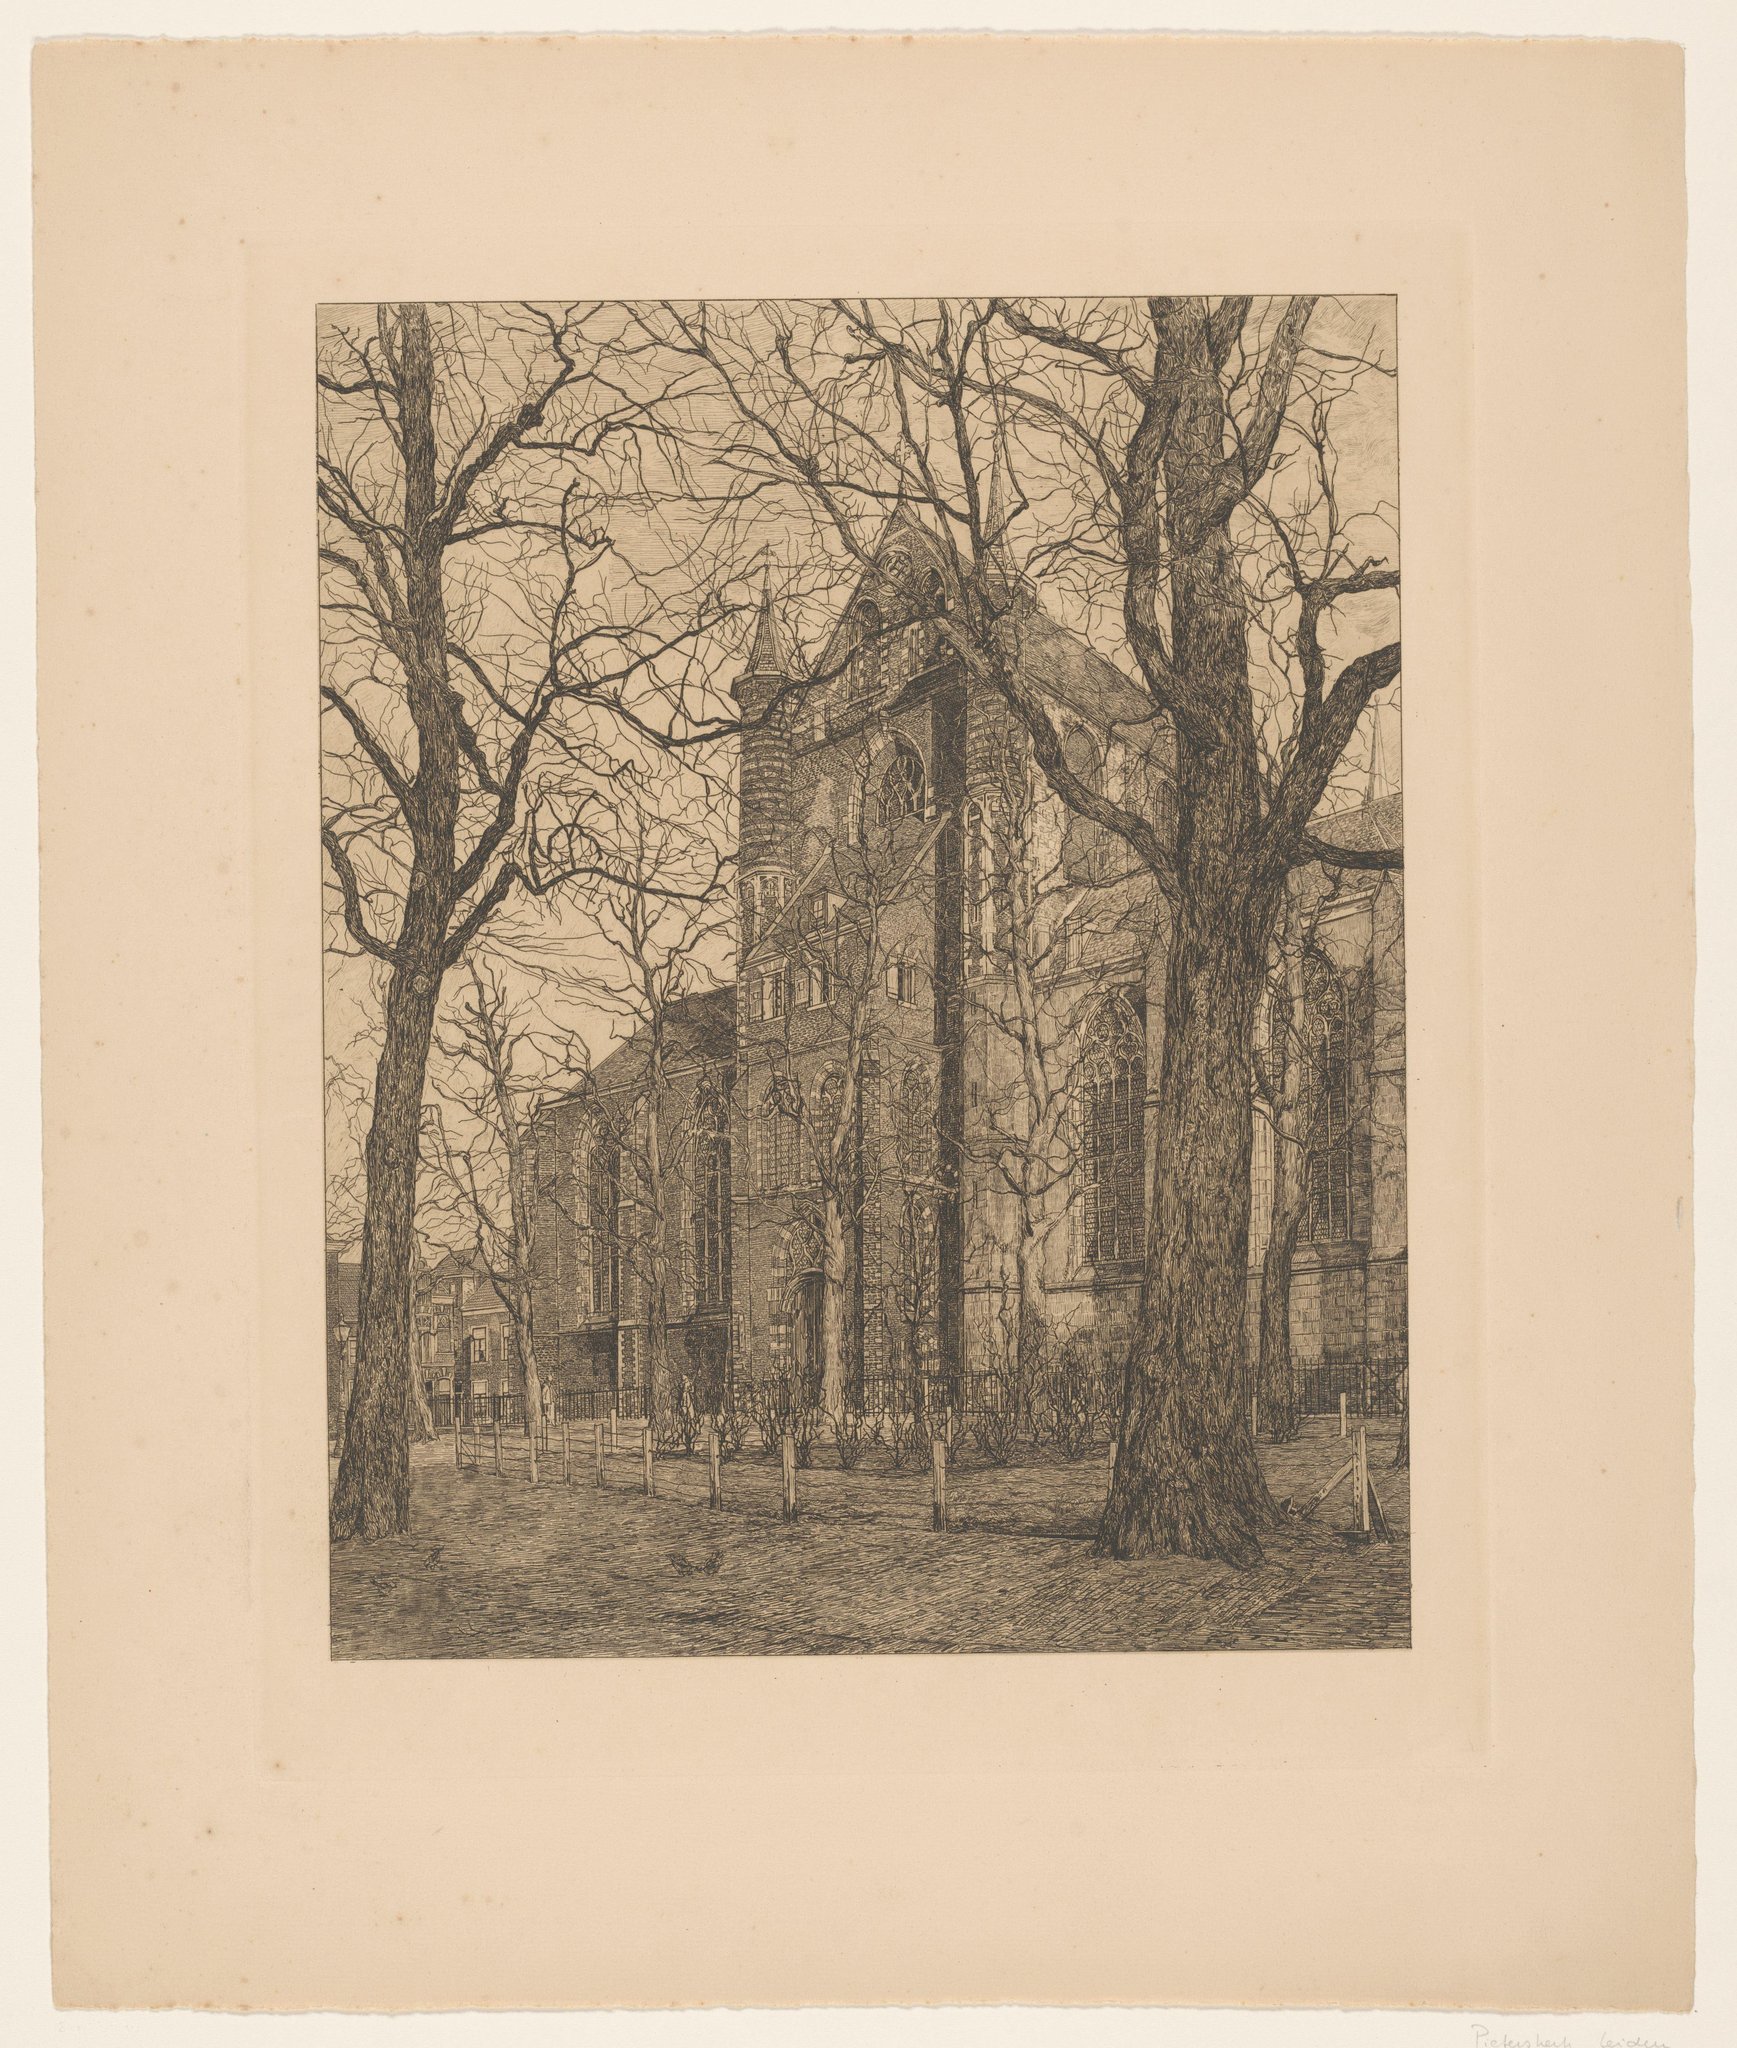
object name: print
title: Pieterskerk in Leiden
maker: gerrit haverkamp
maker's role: print maker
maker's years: 1872-1926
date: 1882-1926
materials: paper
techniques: etching, intaglio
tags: trees, church (exterior)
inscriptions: watermark, collector's mark: Lugt 2228